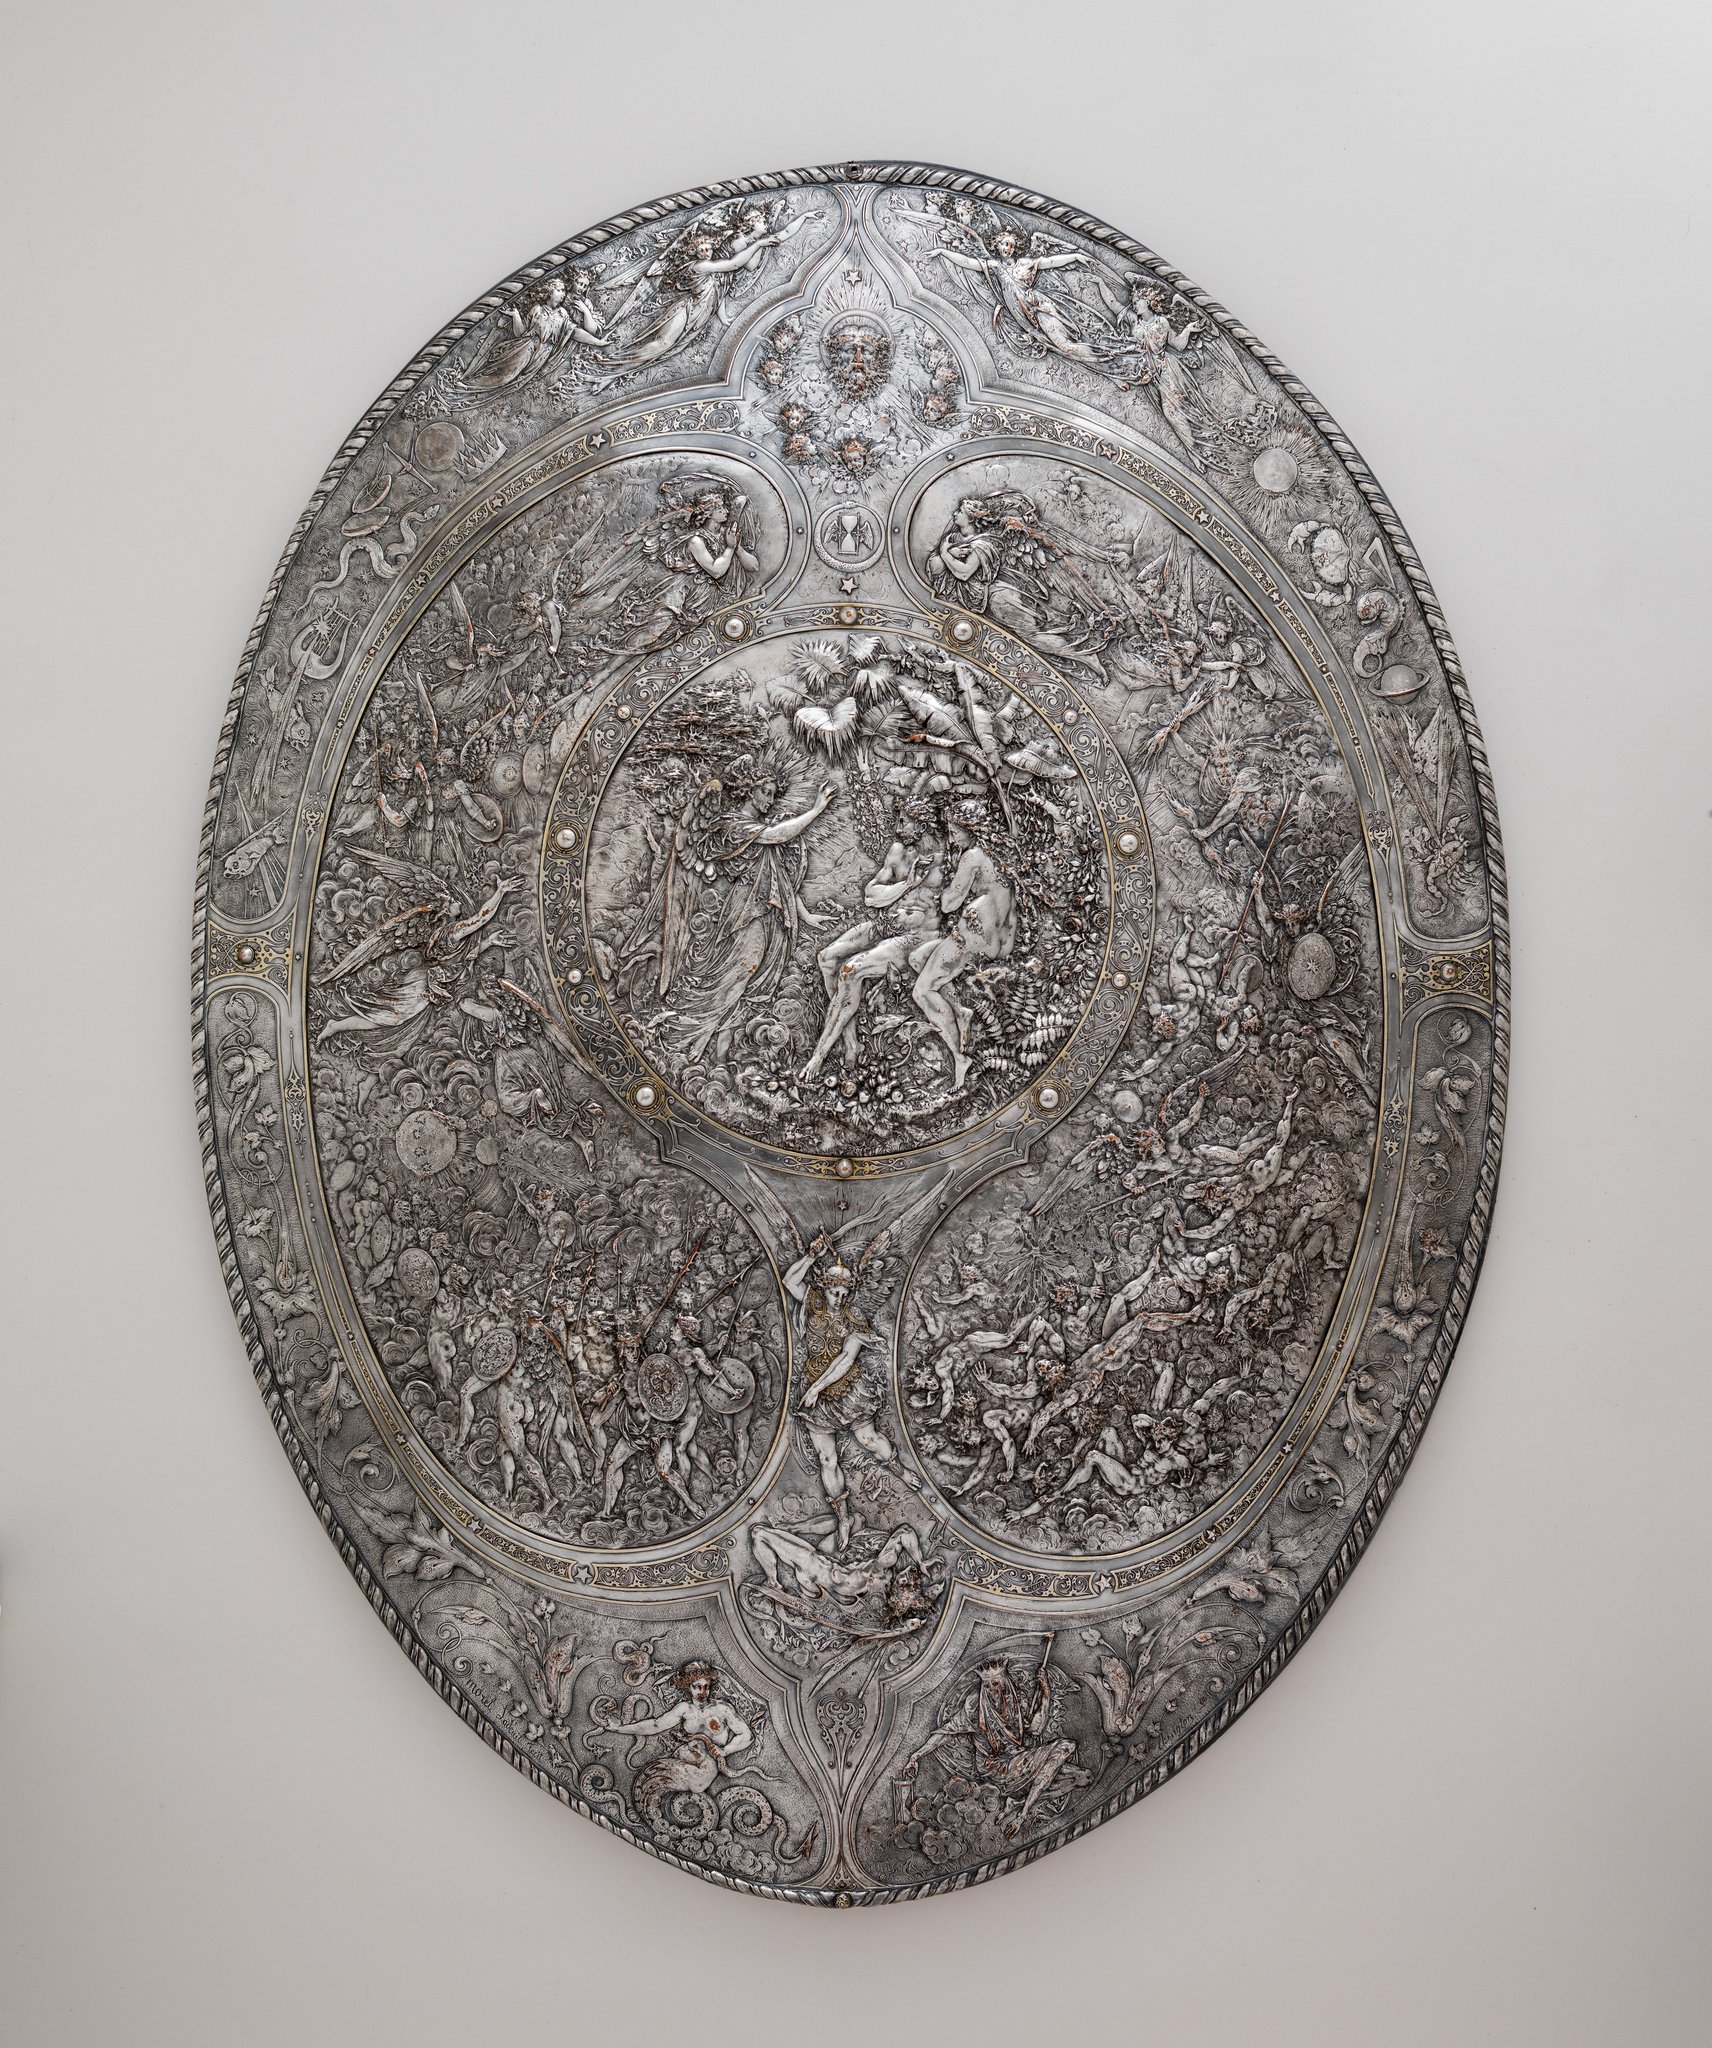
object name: shield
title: The Milton Shield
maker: elkington & co.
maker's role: manufactory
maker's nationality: british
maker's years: 1829-1963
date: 1867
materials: copper, silver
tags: male nudes,female nudes,angels,adam,eve